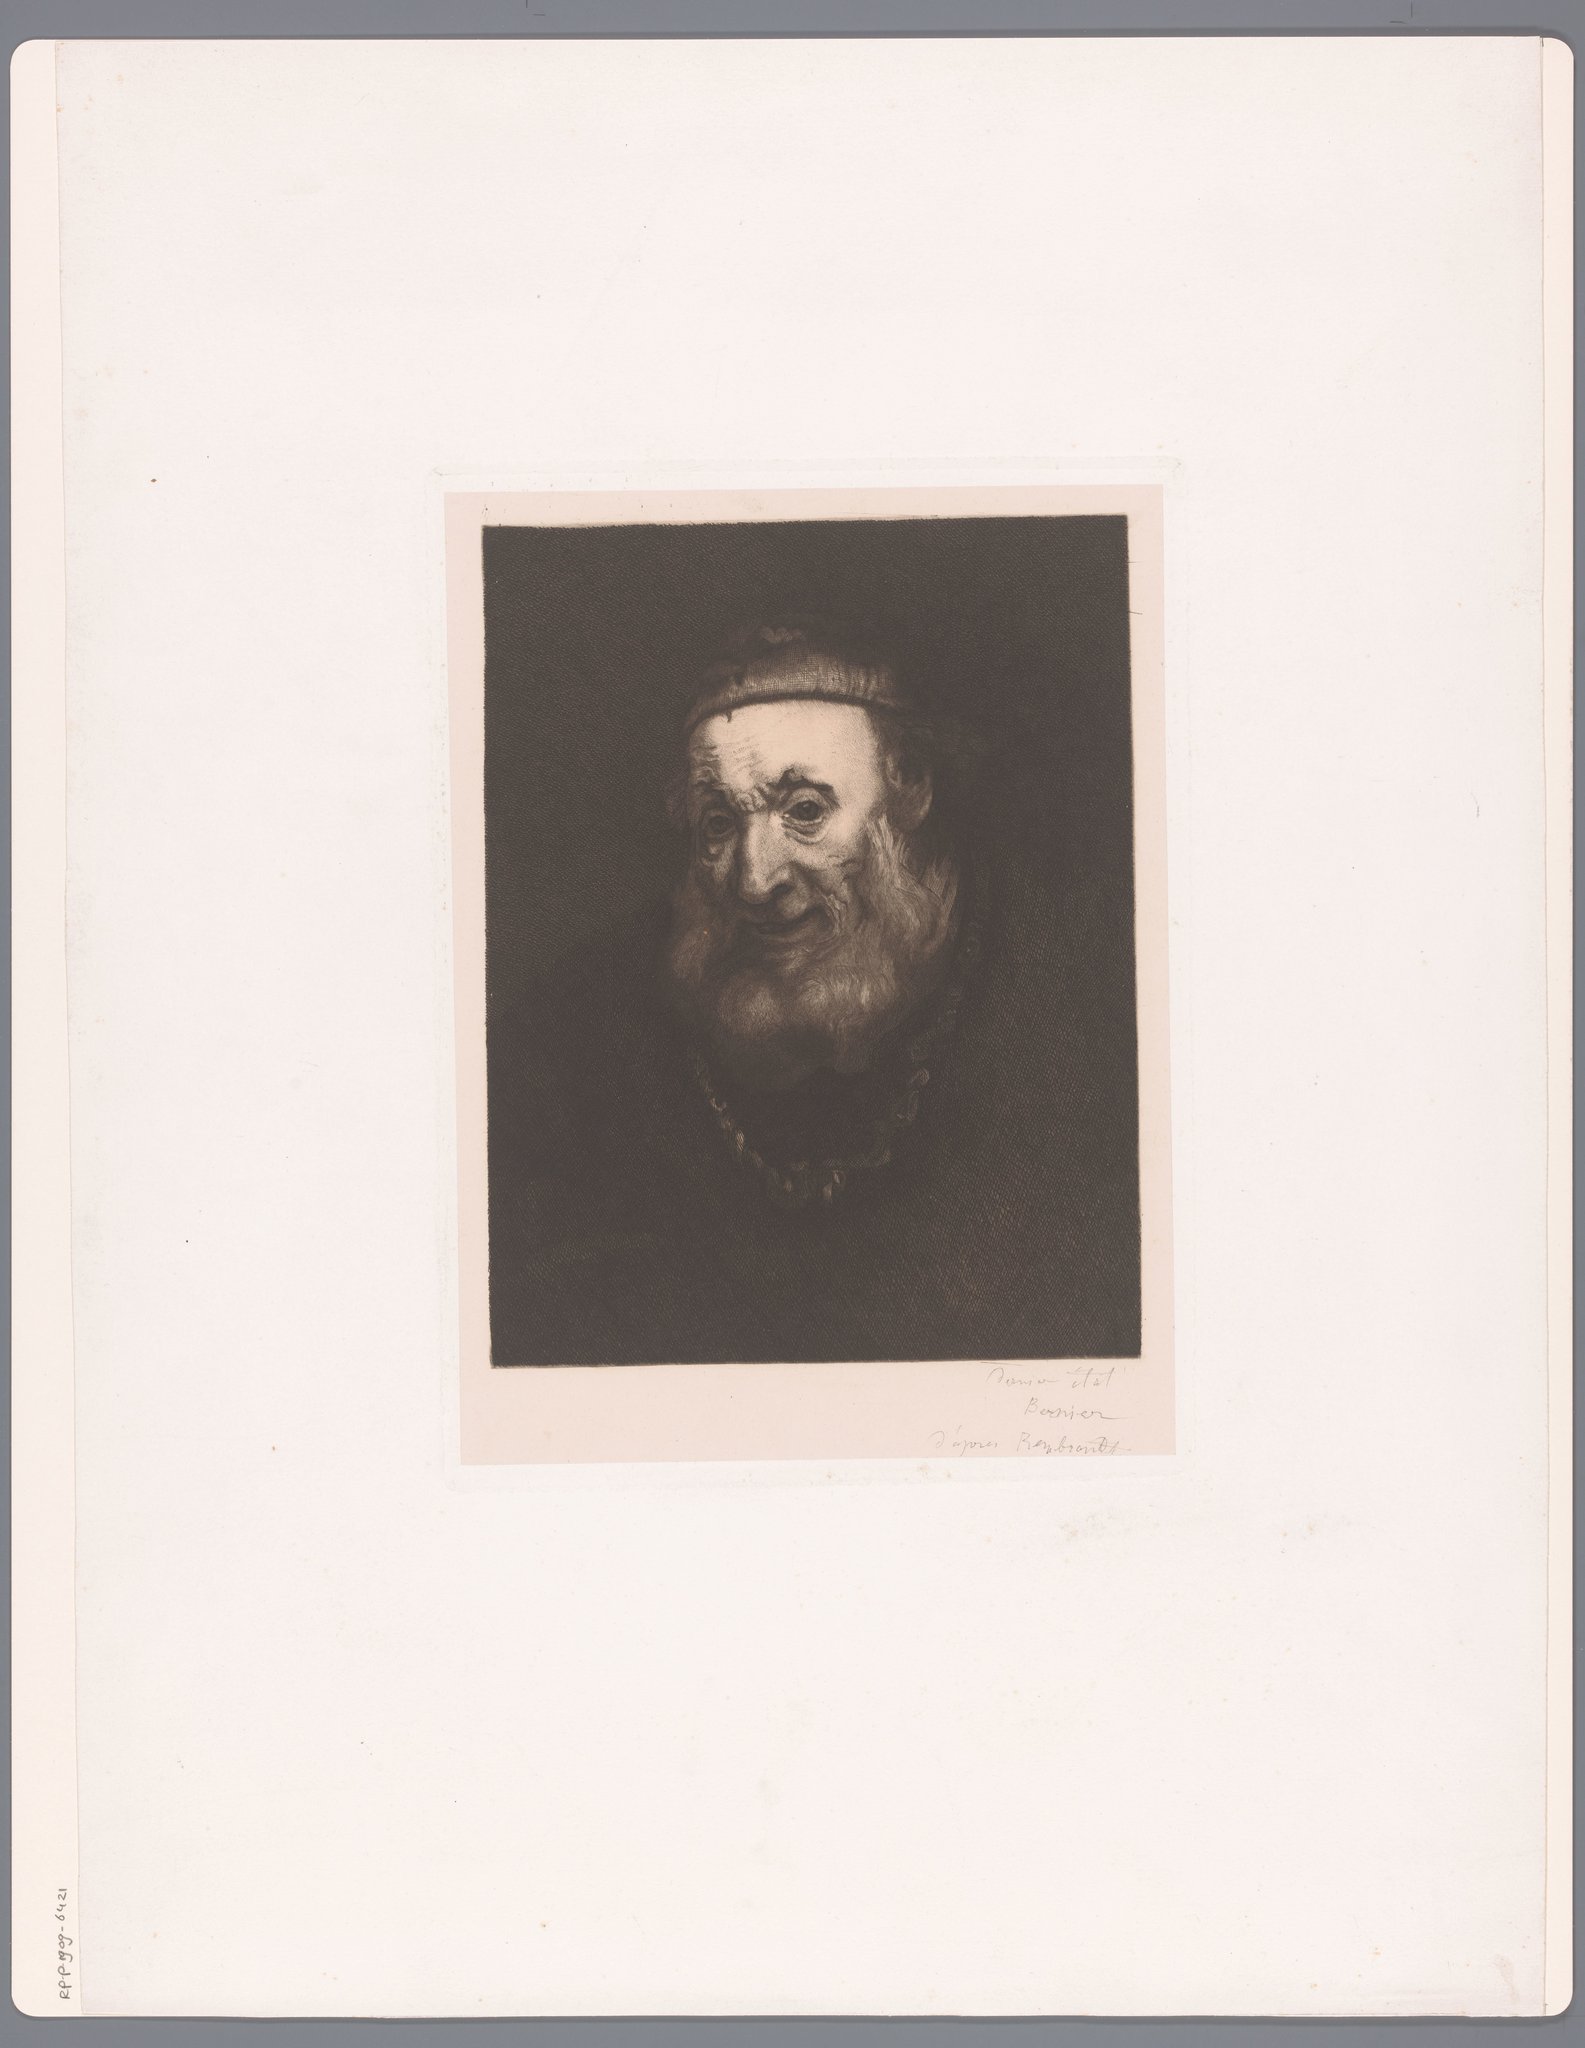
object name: print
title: Kop van een grijsaard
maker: charles théodore bernier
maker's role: print maker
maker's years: 1871-1950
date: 1887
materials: paper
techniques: drypoint, etching, intaglio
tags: old man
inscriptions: collector's mark